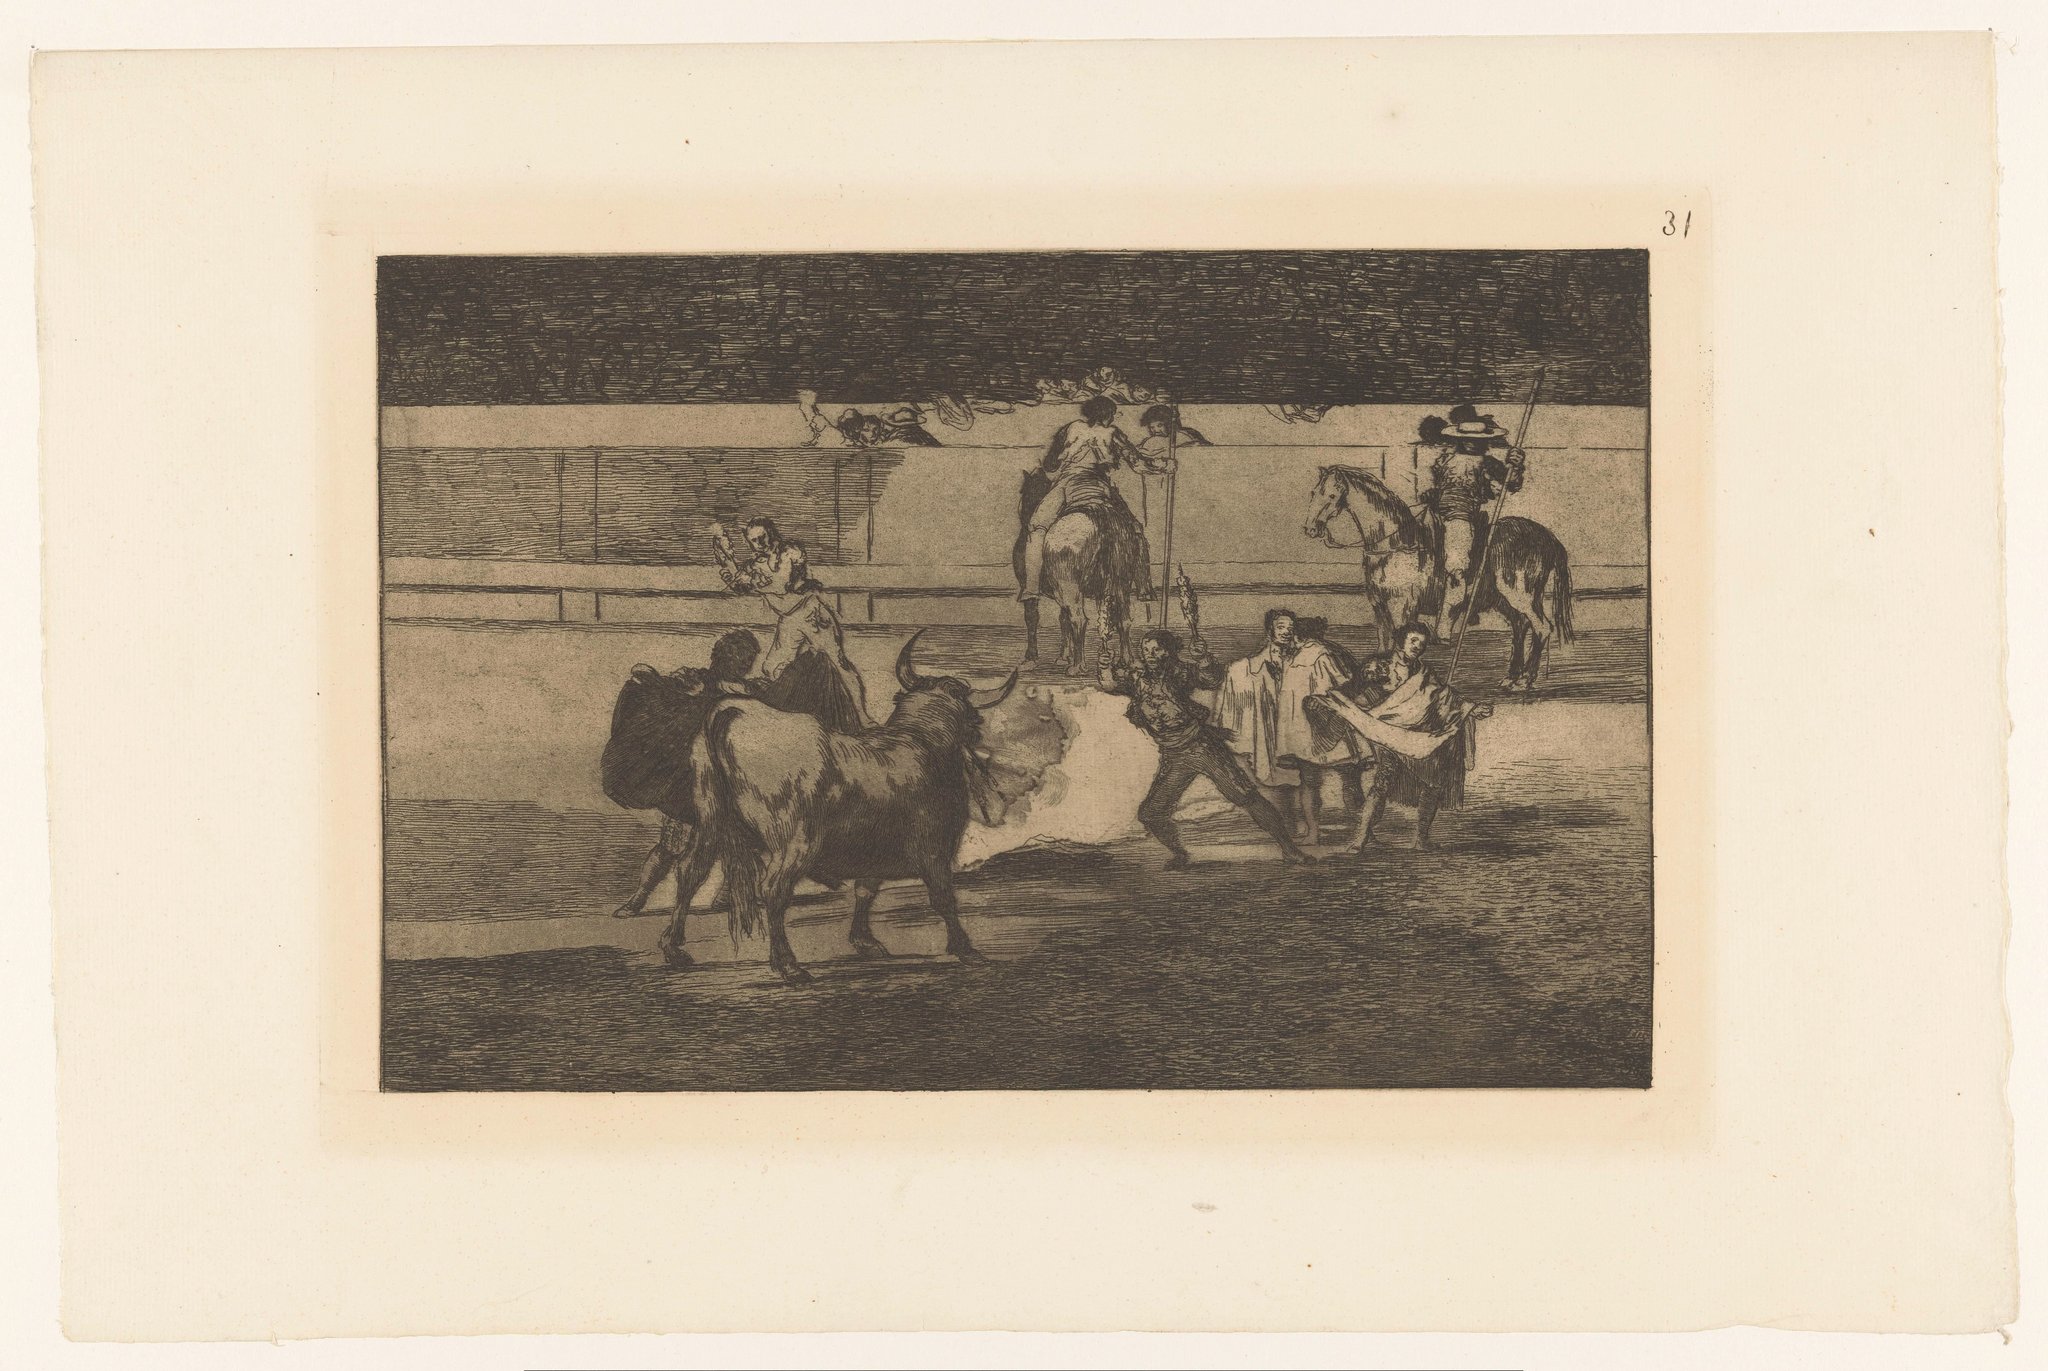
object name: print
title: La Taureaumachie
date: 1815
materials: paper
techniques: aquatint, etching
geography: spain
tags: bullfight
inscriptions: collector's mark: Lugt 2228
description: Deze prent maakt deel uit van een serie van 40 prenten door Francisco de Goya met voorstellingen van stierengevechten. De eerste editie bestond uit 33 genummerde prenten en werd uitgegeven in 1816. Dit betreft de derde editie, uitgegeven in 1876 door Eugène Loizelet en door hem voorzien van een titelprent en lijst met titels. Naast de 33 prenten publiceerde Loizelet ook de prenten die door Goya op de achterkanten van 7 van de platen werden geëtst. Deze zijn niet voorzien van nummers maar van de letters A-G.